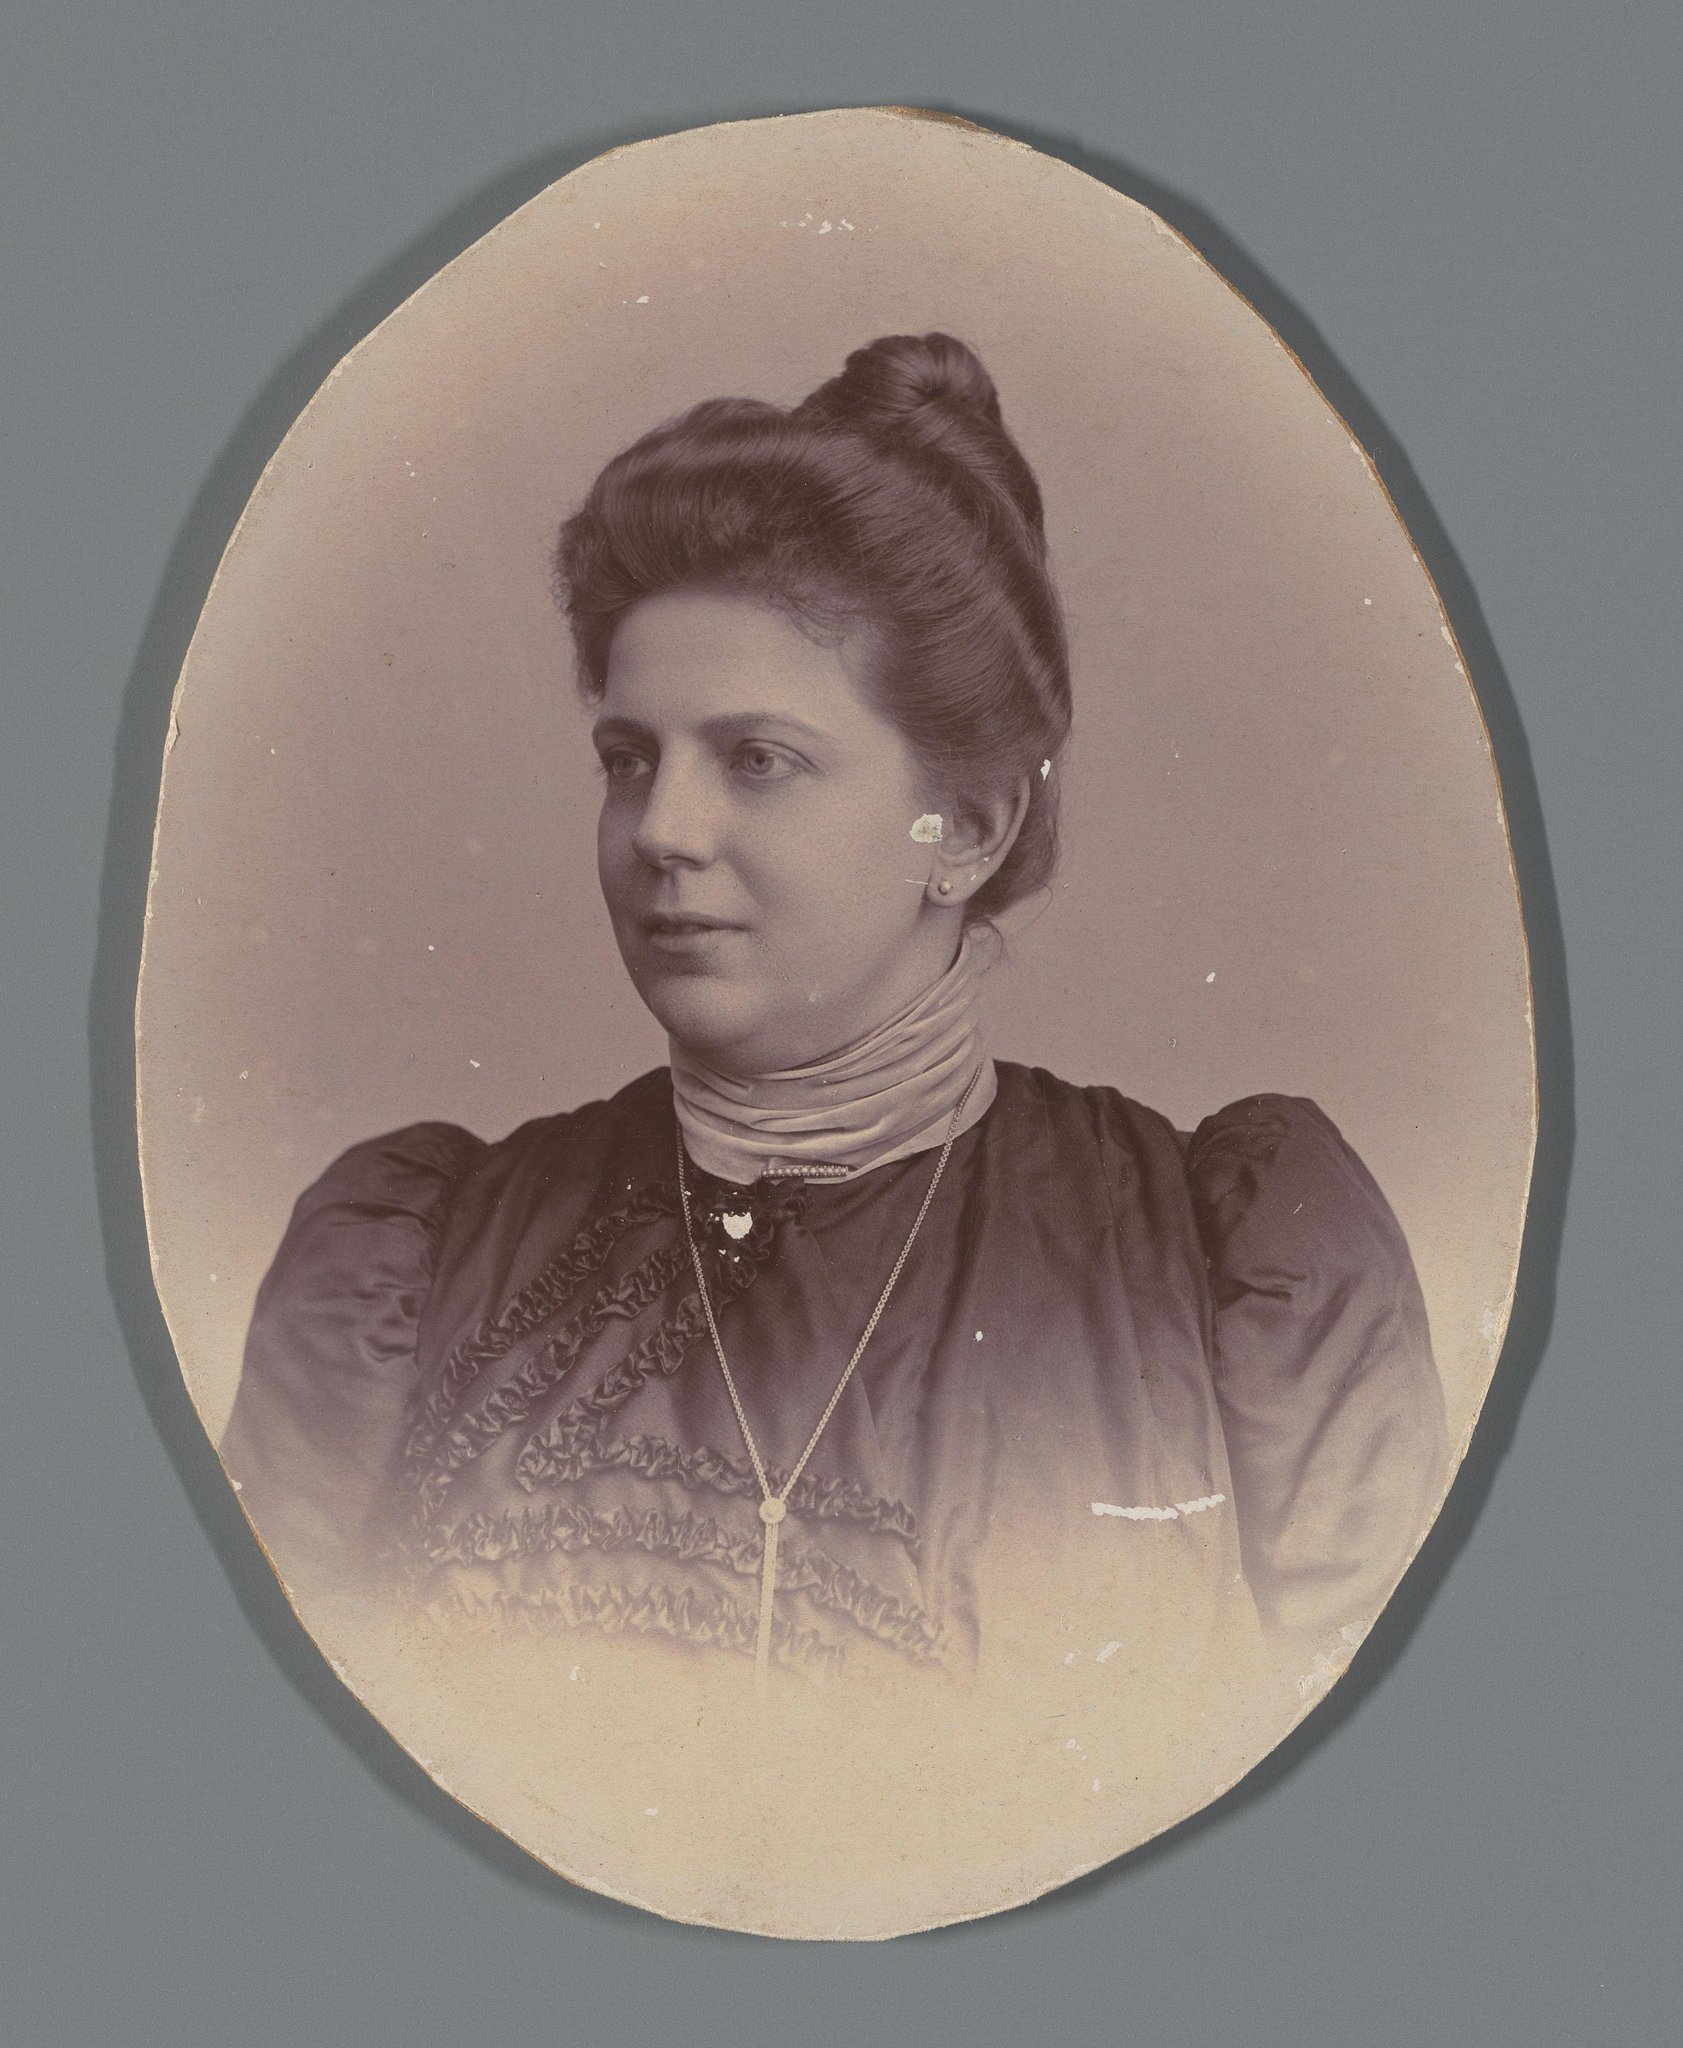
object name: photograph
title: Studioportret van Pauline van den Berg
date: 1895-1910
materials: cardboard, photographic support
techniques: albumen print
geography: batavia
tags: the hague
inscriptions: name: ‘Photografie / CHARLS & vab ES &’, name: ‘Pau v. Blommen’